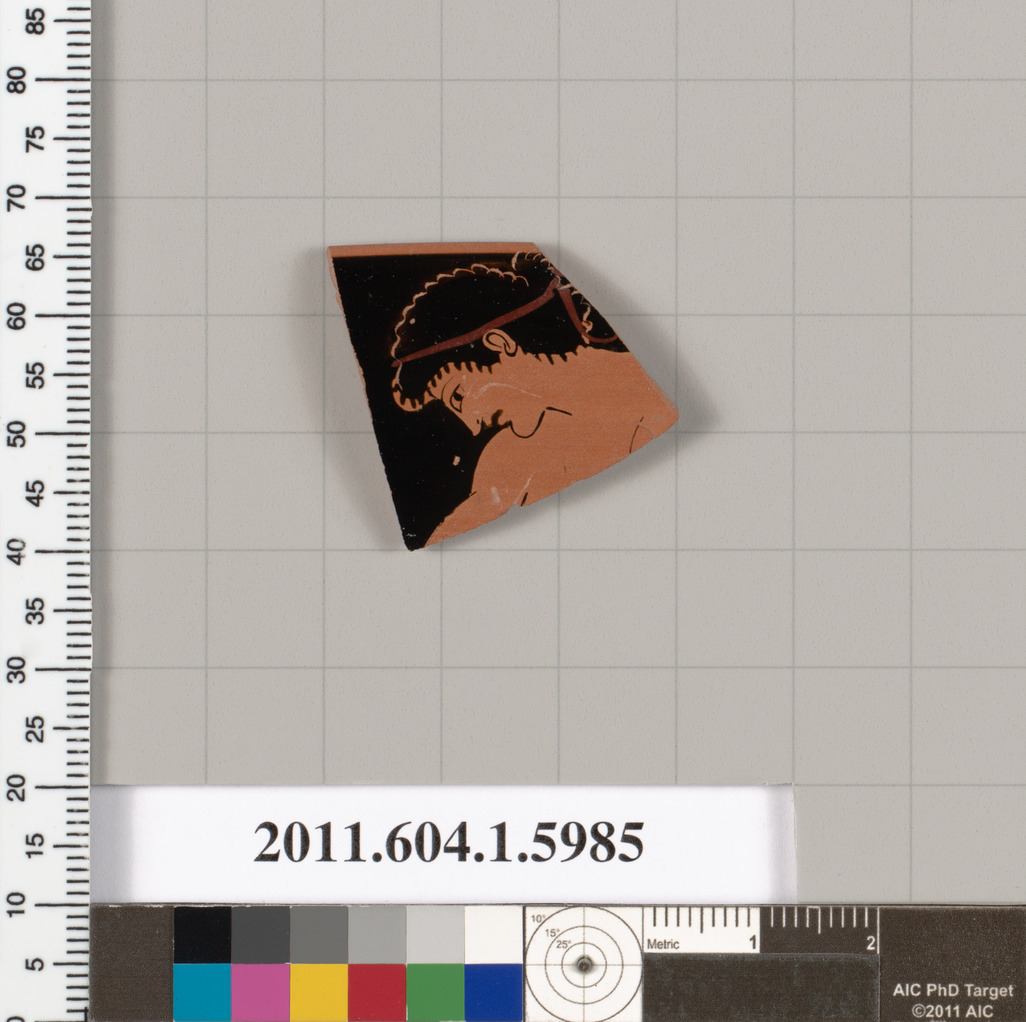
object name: kylix fragment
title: Terracotta rim fragment of a kylix (drinking cup)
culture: greek, attic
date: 510-500 BCE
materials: terracotta